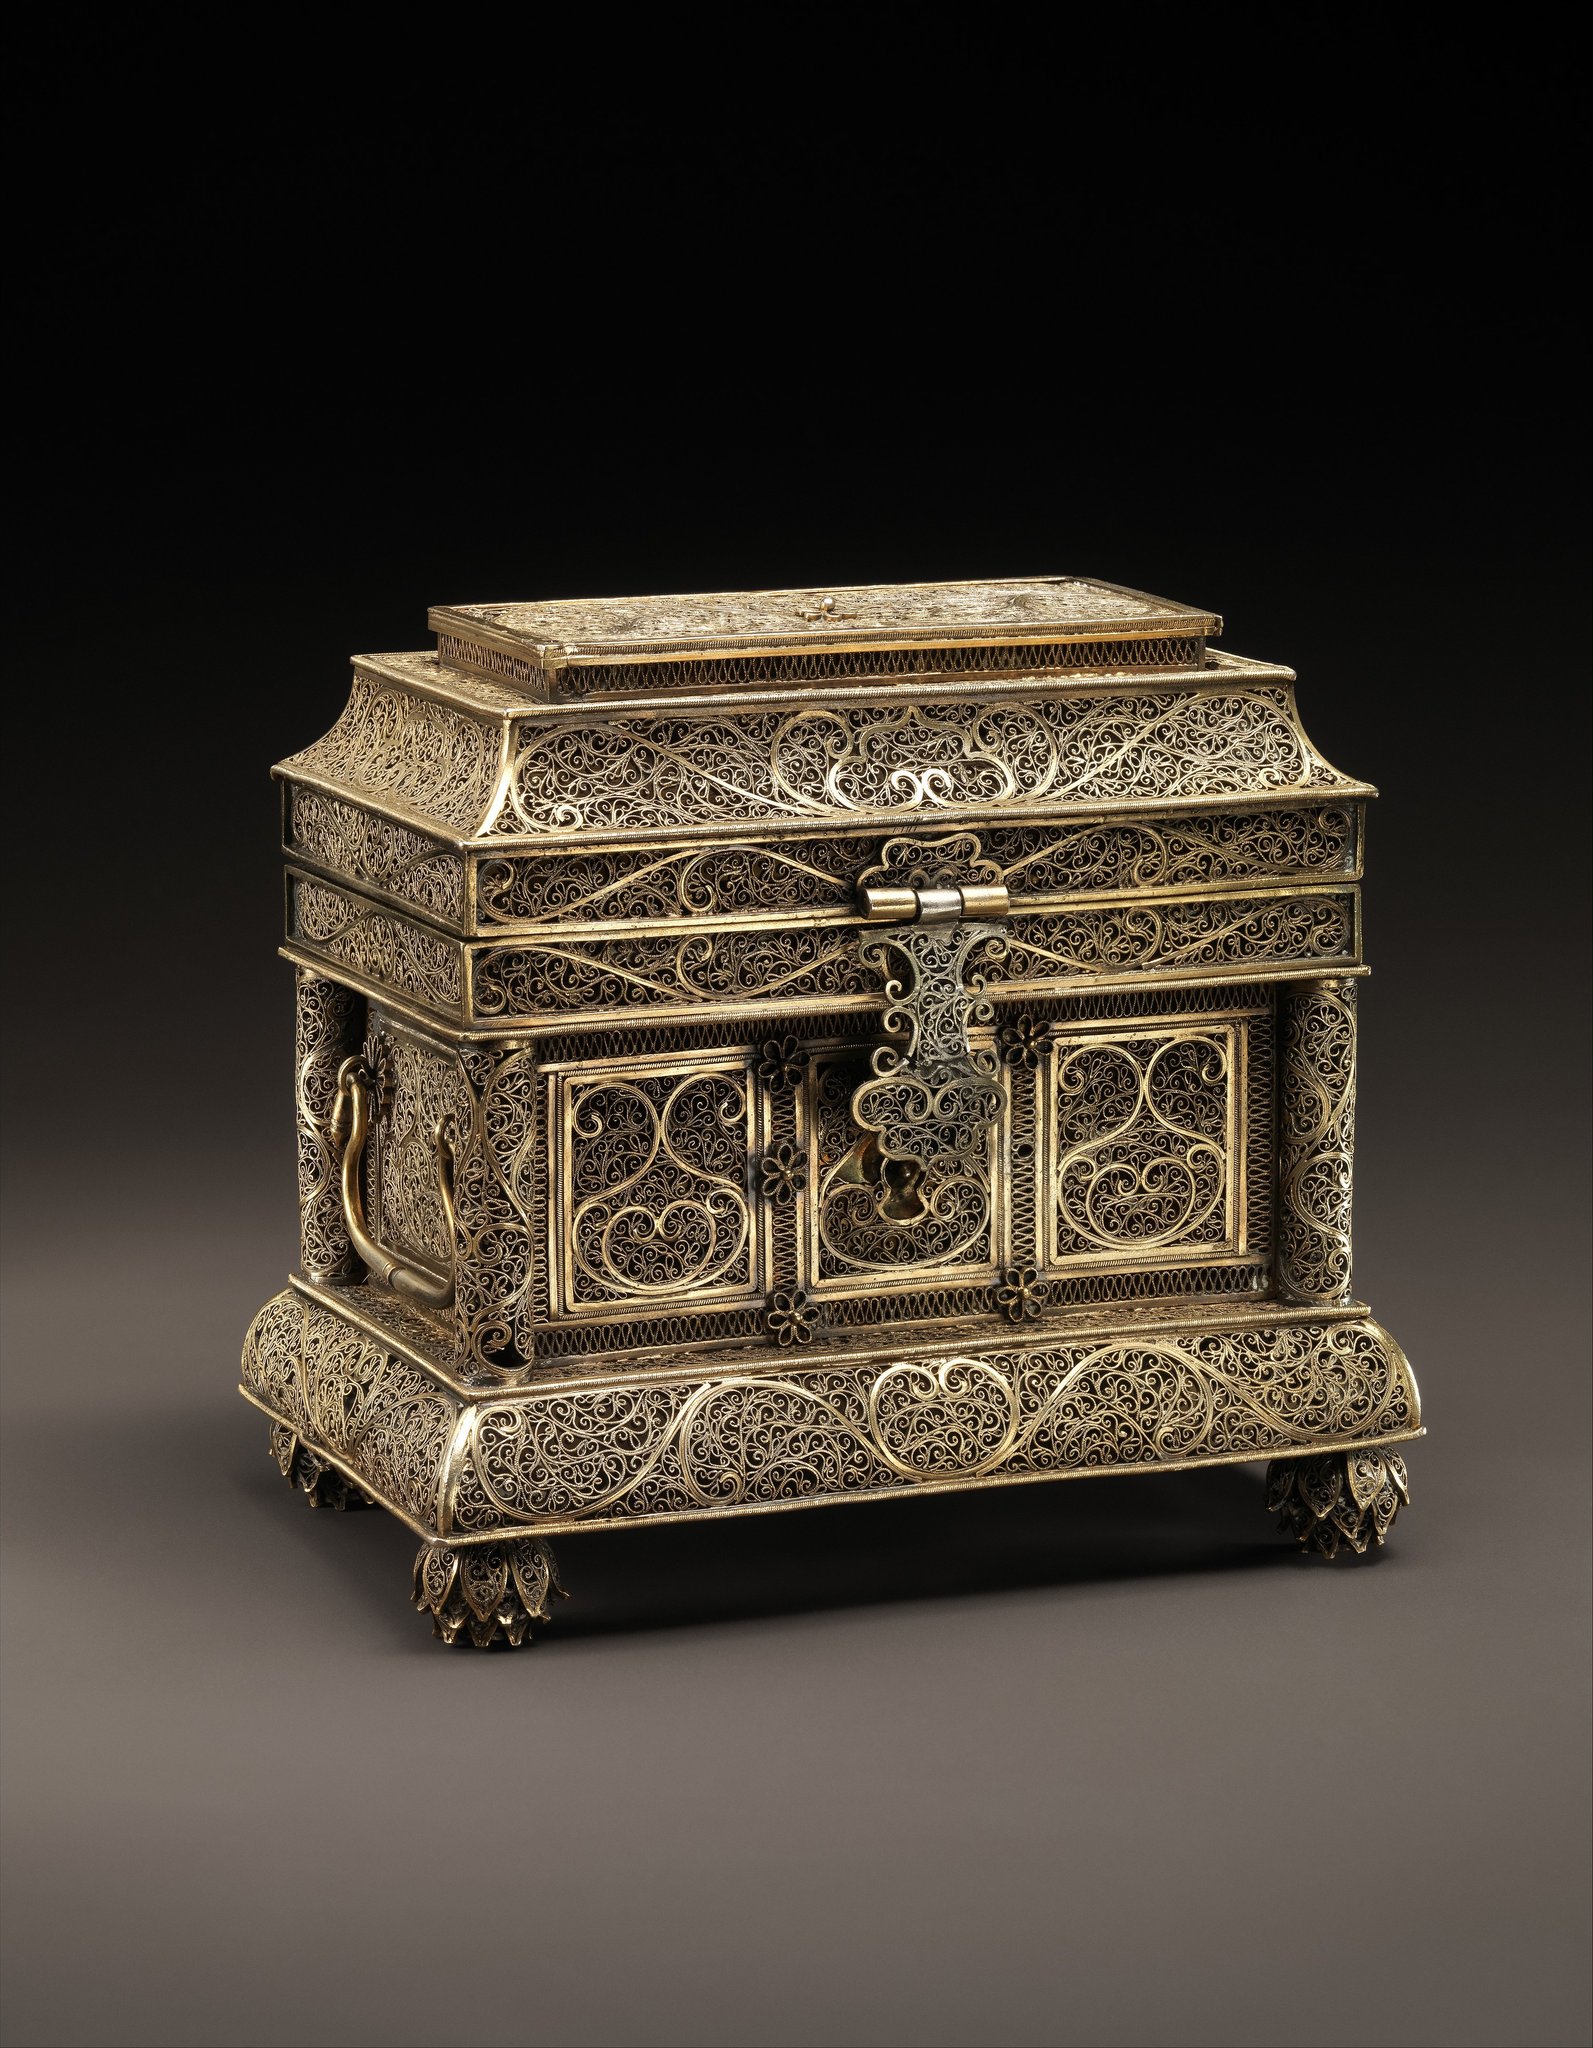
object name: box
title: Filigree Casket with Sliding Top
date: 1601-1700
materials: gilt, silver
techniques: filigree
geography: india